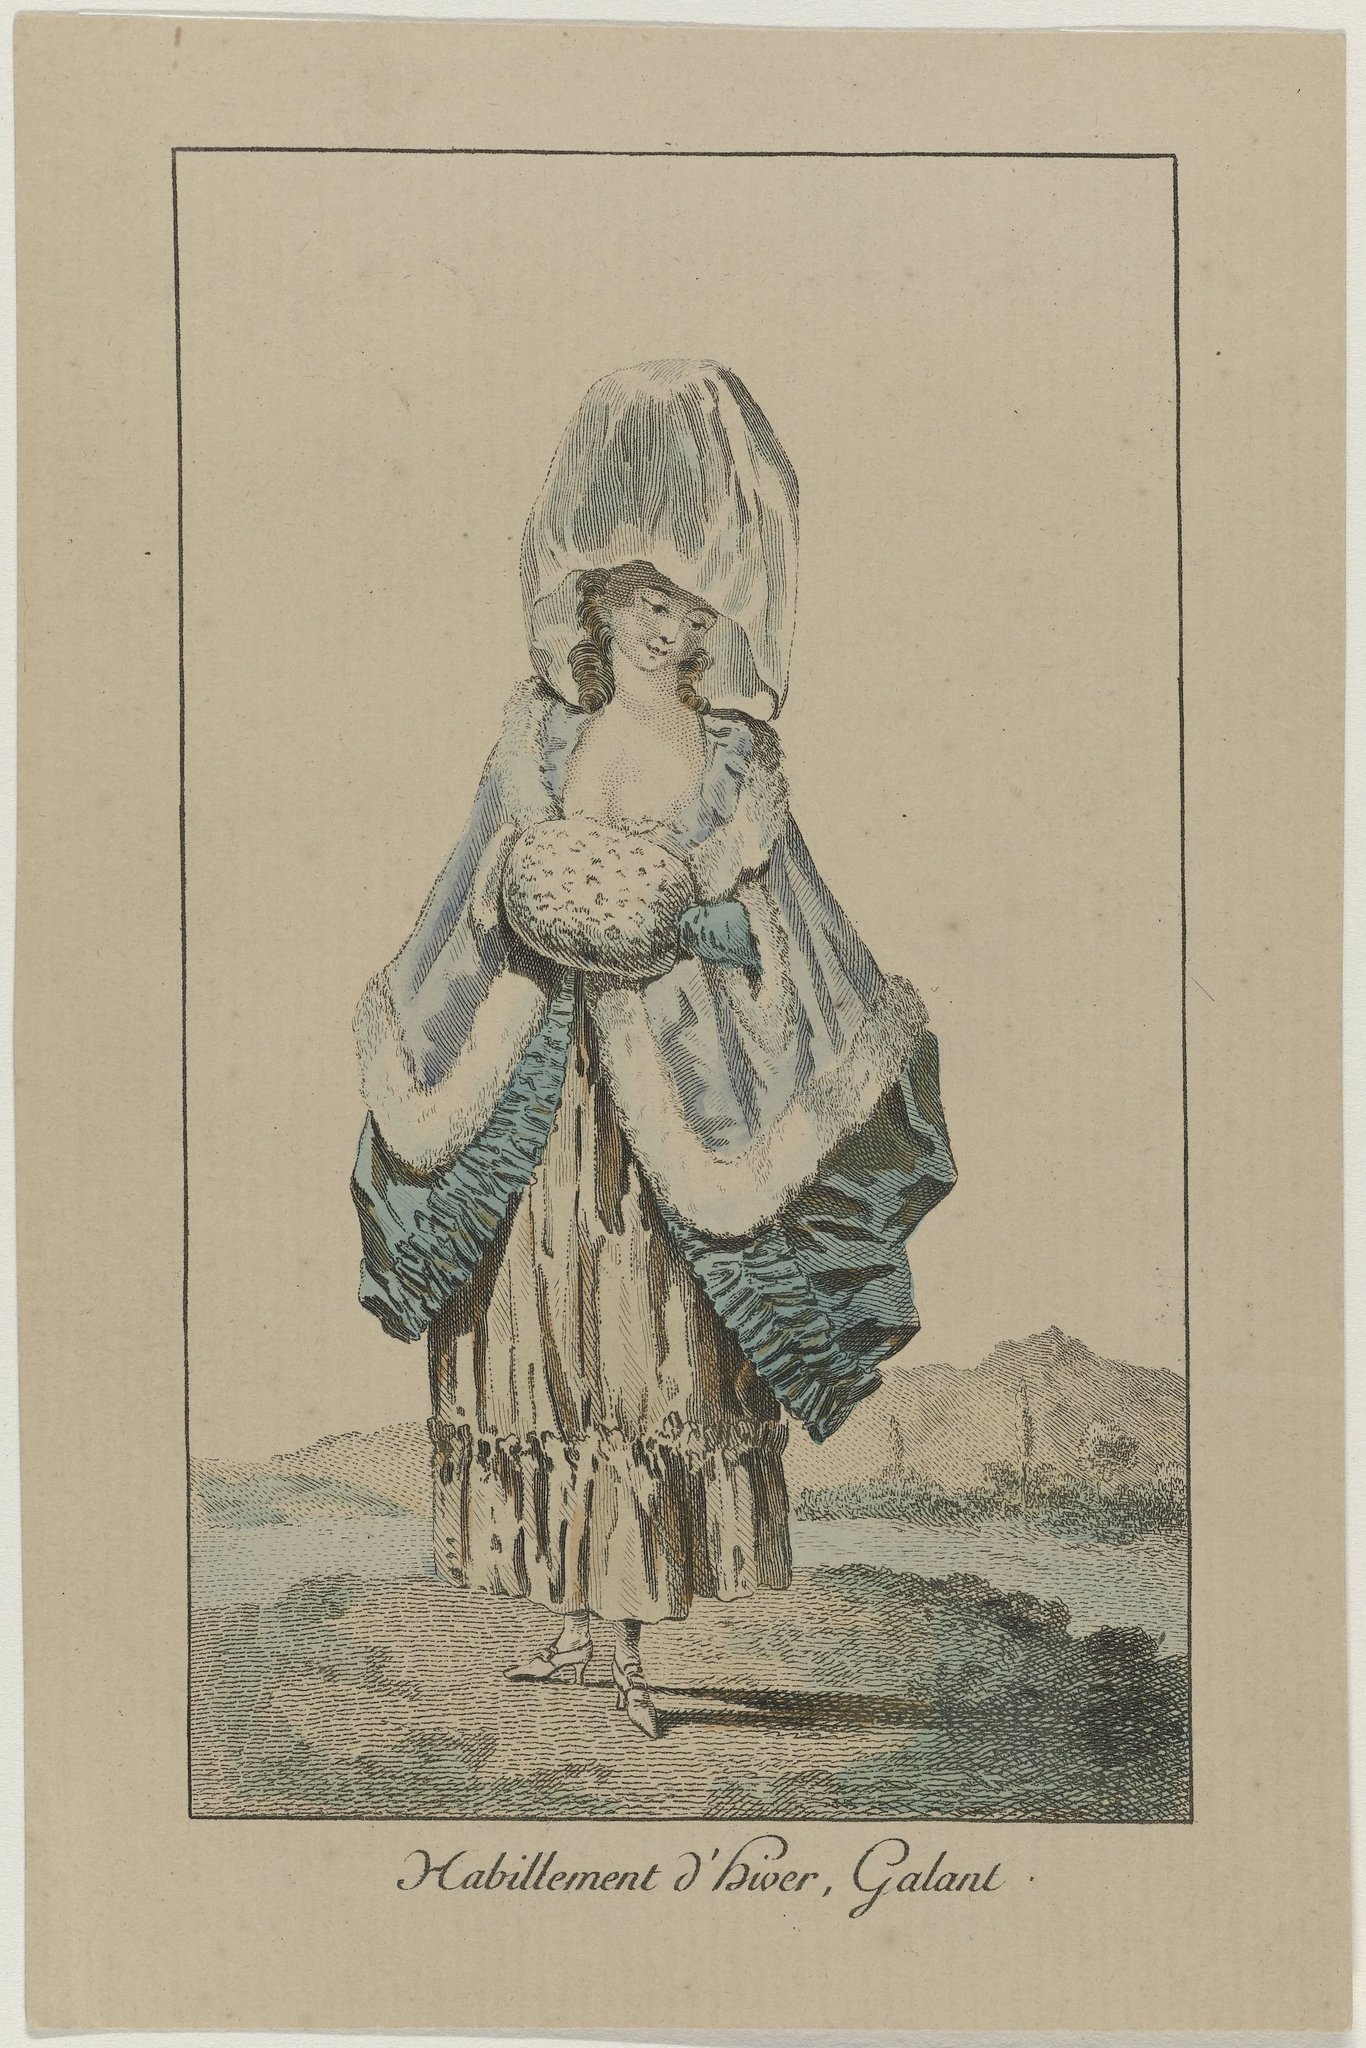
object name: costume print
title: Staande vrouw in winterkleren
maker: Anonymous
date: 1778-1800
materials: paper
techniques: engraving, hand coloring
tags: coat (+ women's clothes), head-gear (+ women's clothes), fashion plates, skirt (+ women's clothes), muff (+ women's clothes), dress, gown: robe à la polonaise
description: Staande vrouw gekleed in een robe á la polonaise met lage halsuitsnijding waarover een schoudermantel met bont. De handen in een mof van bont. Over het hoge kapsel een sluier (?). De prent is een latere kopie van No. (14) uit de serie Suite des Nouvelles Modes Francoise.